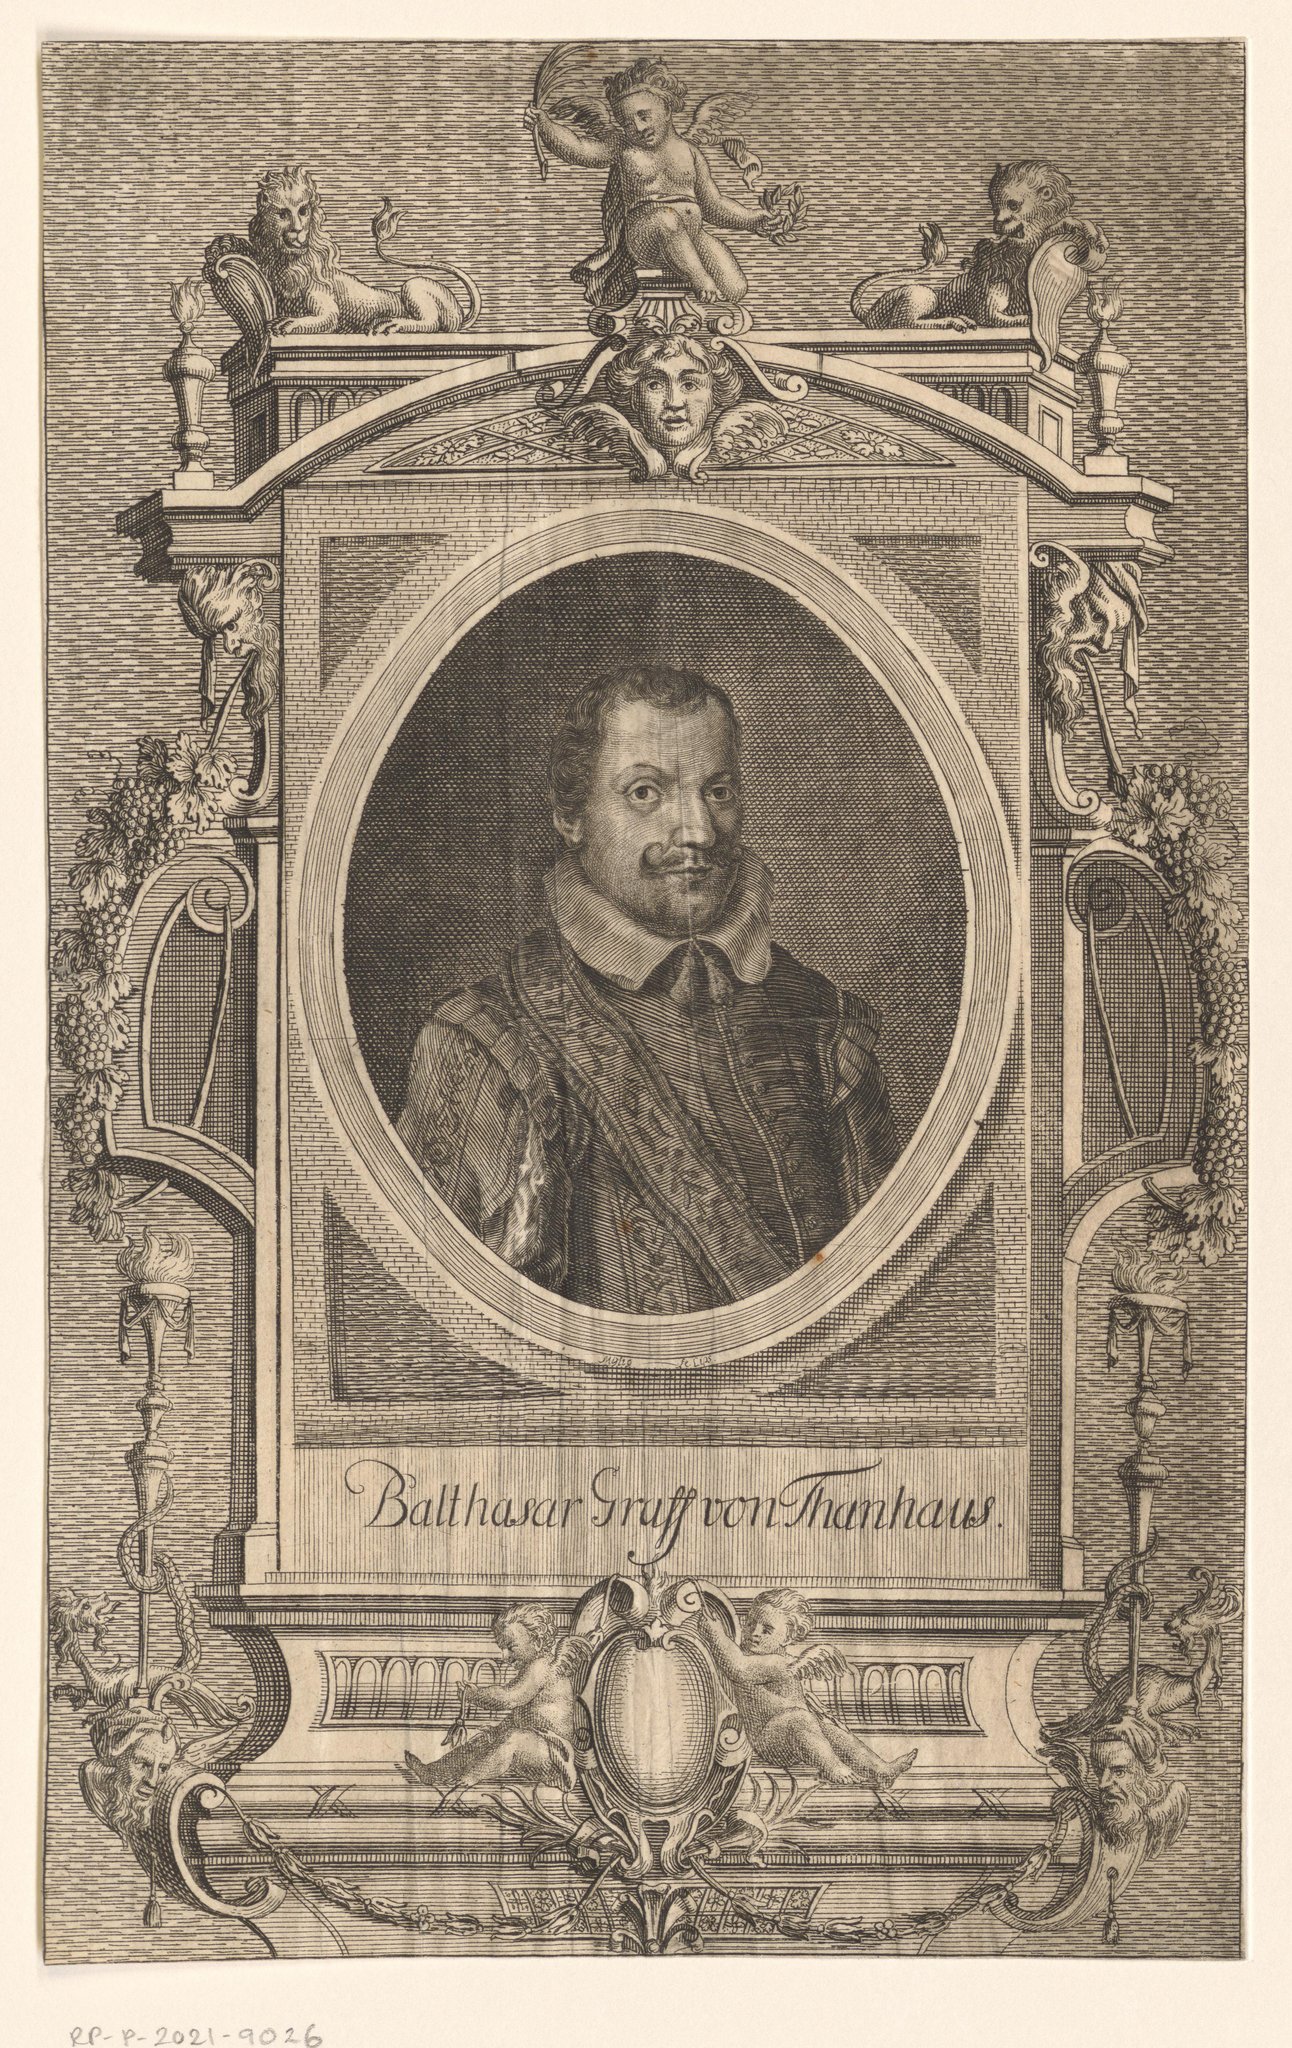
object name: print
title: Portret van Balthasar von Thanhaus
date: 1722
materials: paper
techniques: engraving, etching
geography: leipzig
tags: earl, historical persons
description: Prent uit: Conterfet Kupfferstich (...). Leipzig: Moritz Georg Weidmann, 1722, dl. 2.